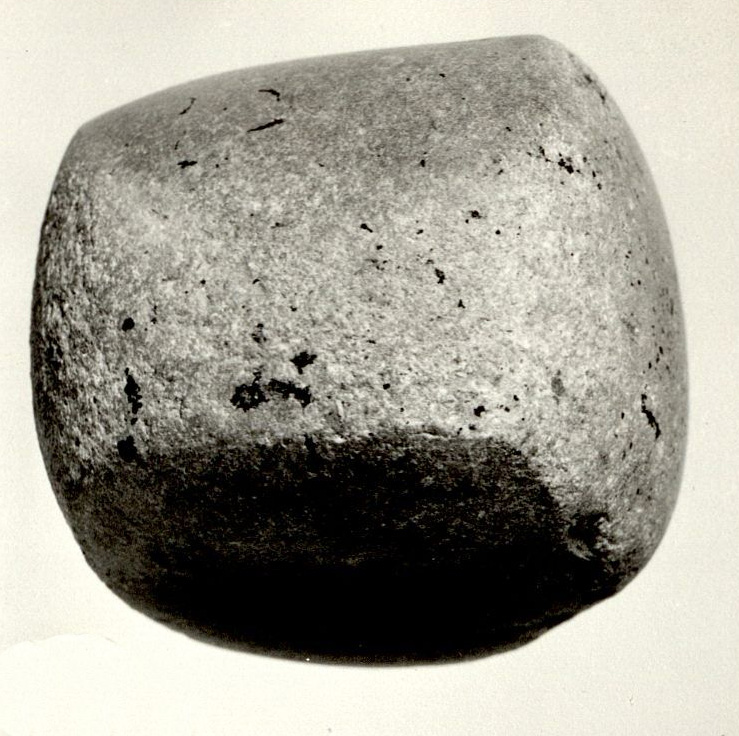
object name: pestle, pounder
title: Pounder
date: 4500-4000 BCE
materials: quartz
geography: egypt